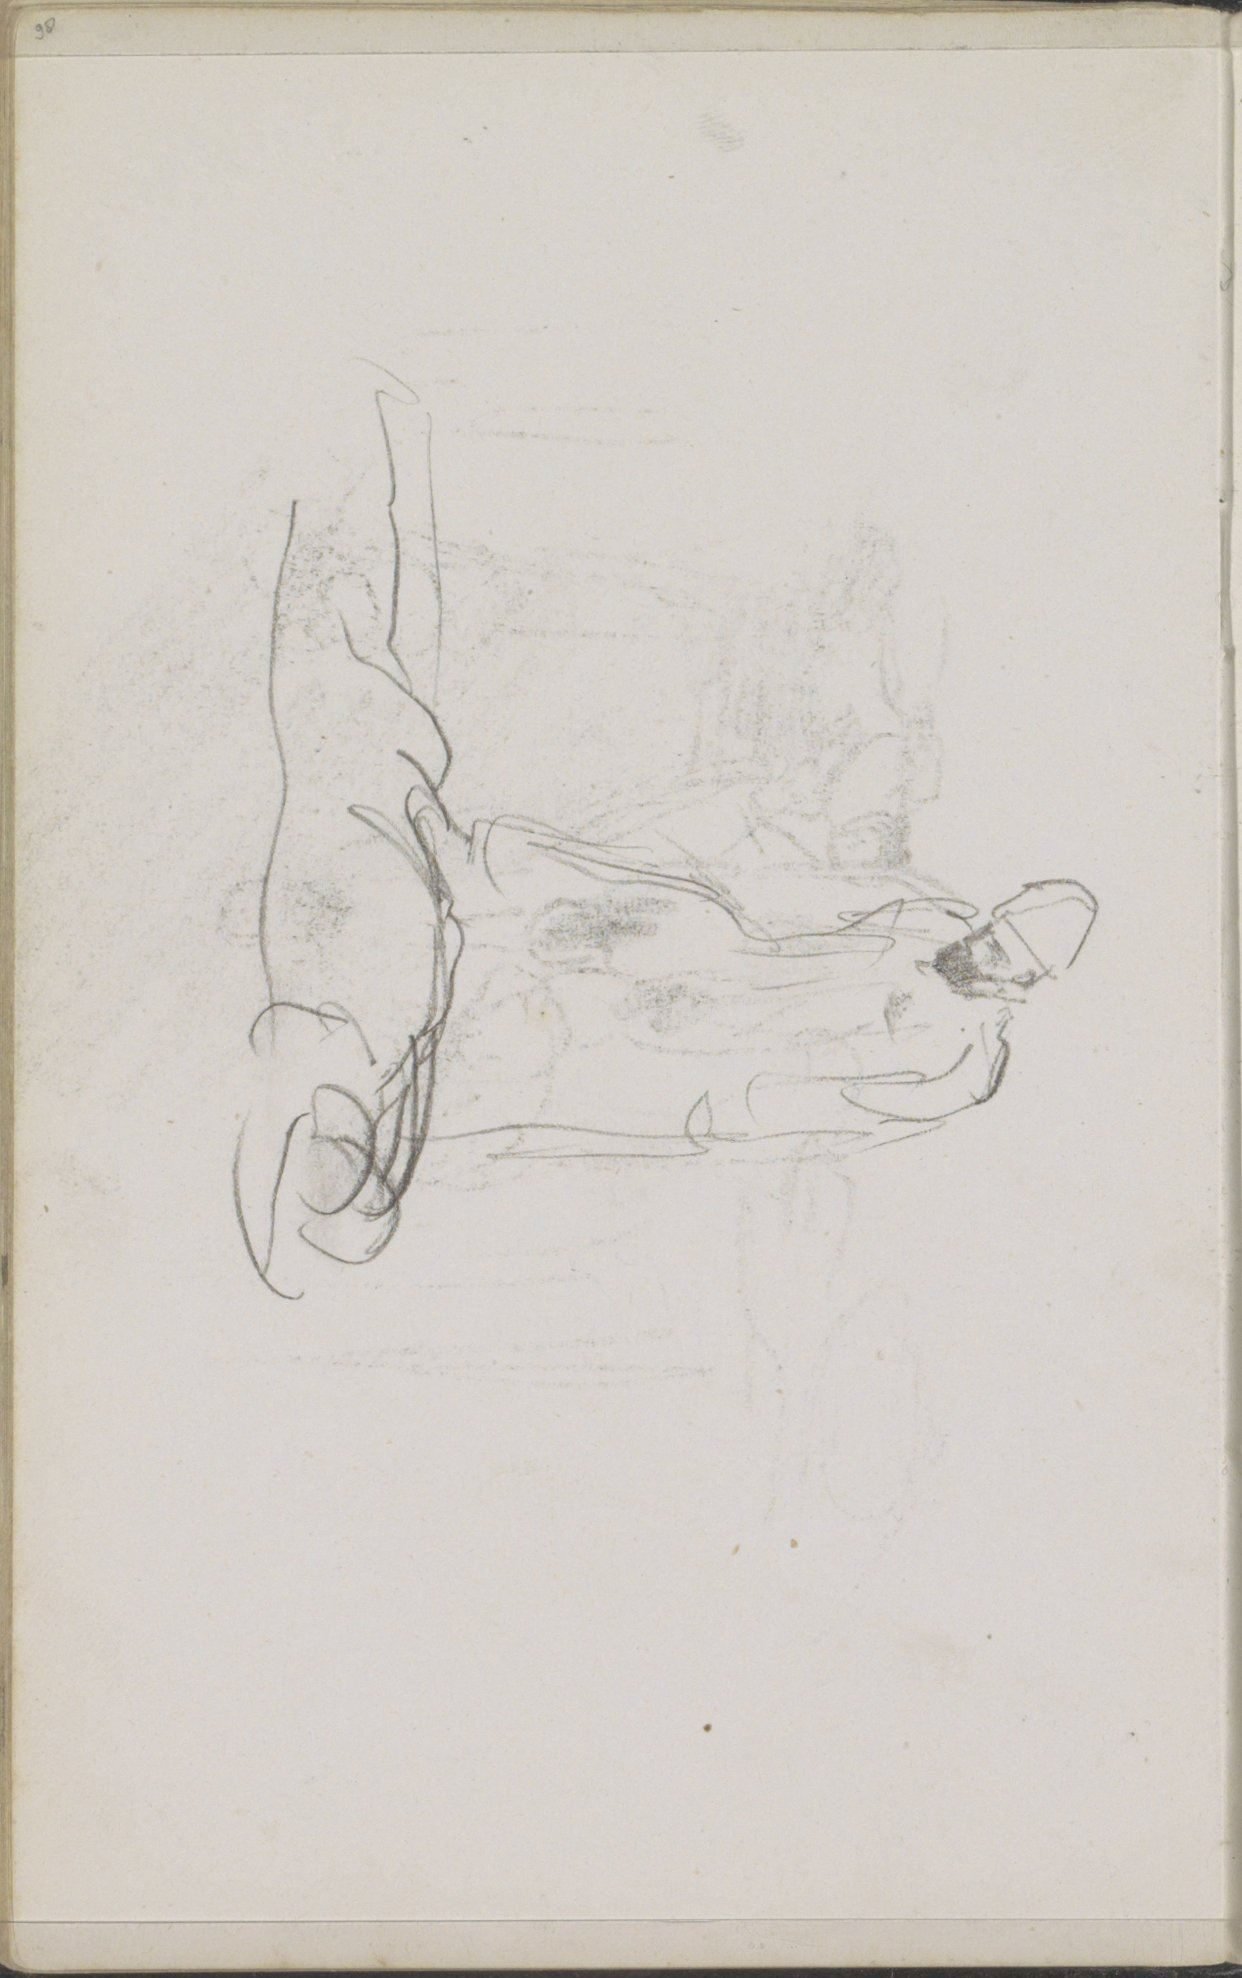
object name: sketchbook leaf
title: Man met baard en opgeheven voet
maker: marius bauer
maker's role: draughtsman, print maker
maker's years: 1867-1932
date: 1896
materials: chalk, paper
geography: turkey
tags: asiatic races and peoples, standing figure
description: De man, waarschijnlijk een imam of derwisj, raakt met zijn voet een liggende figuur aan, vermoedelijk ter genezing. Pagina 98 uit een schetsboek met 53 bladen.